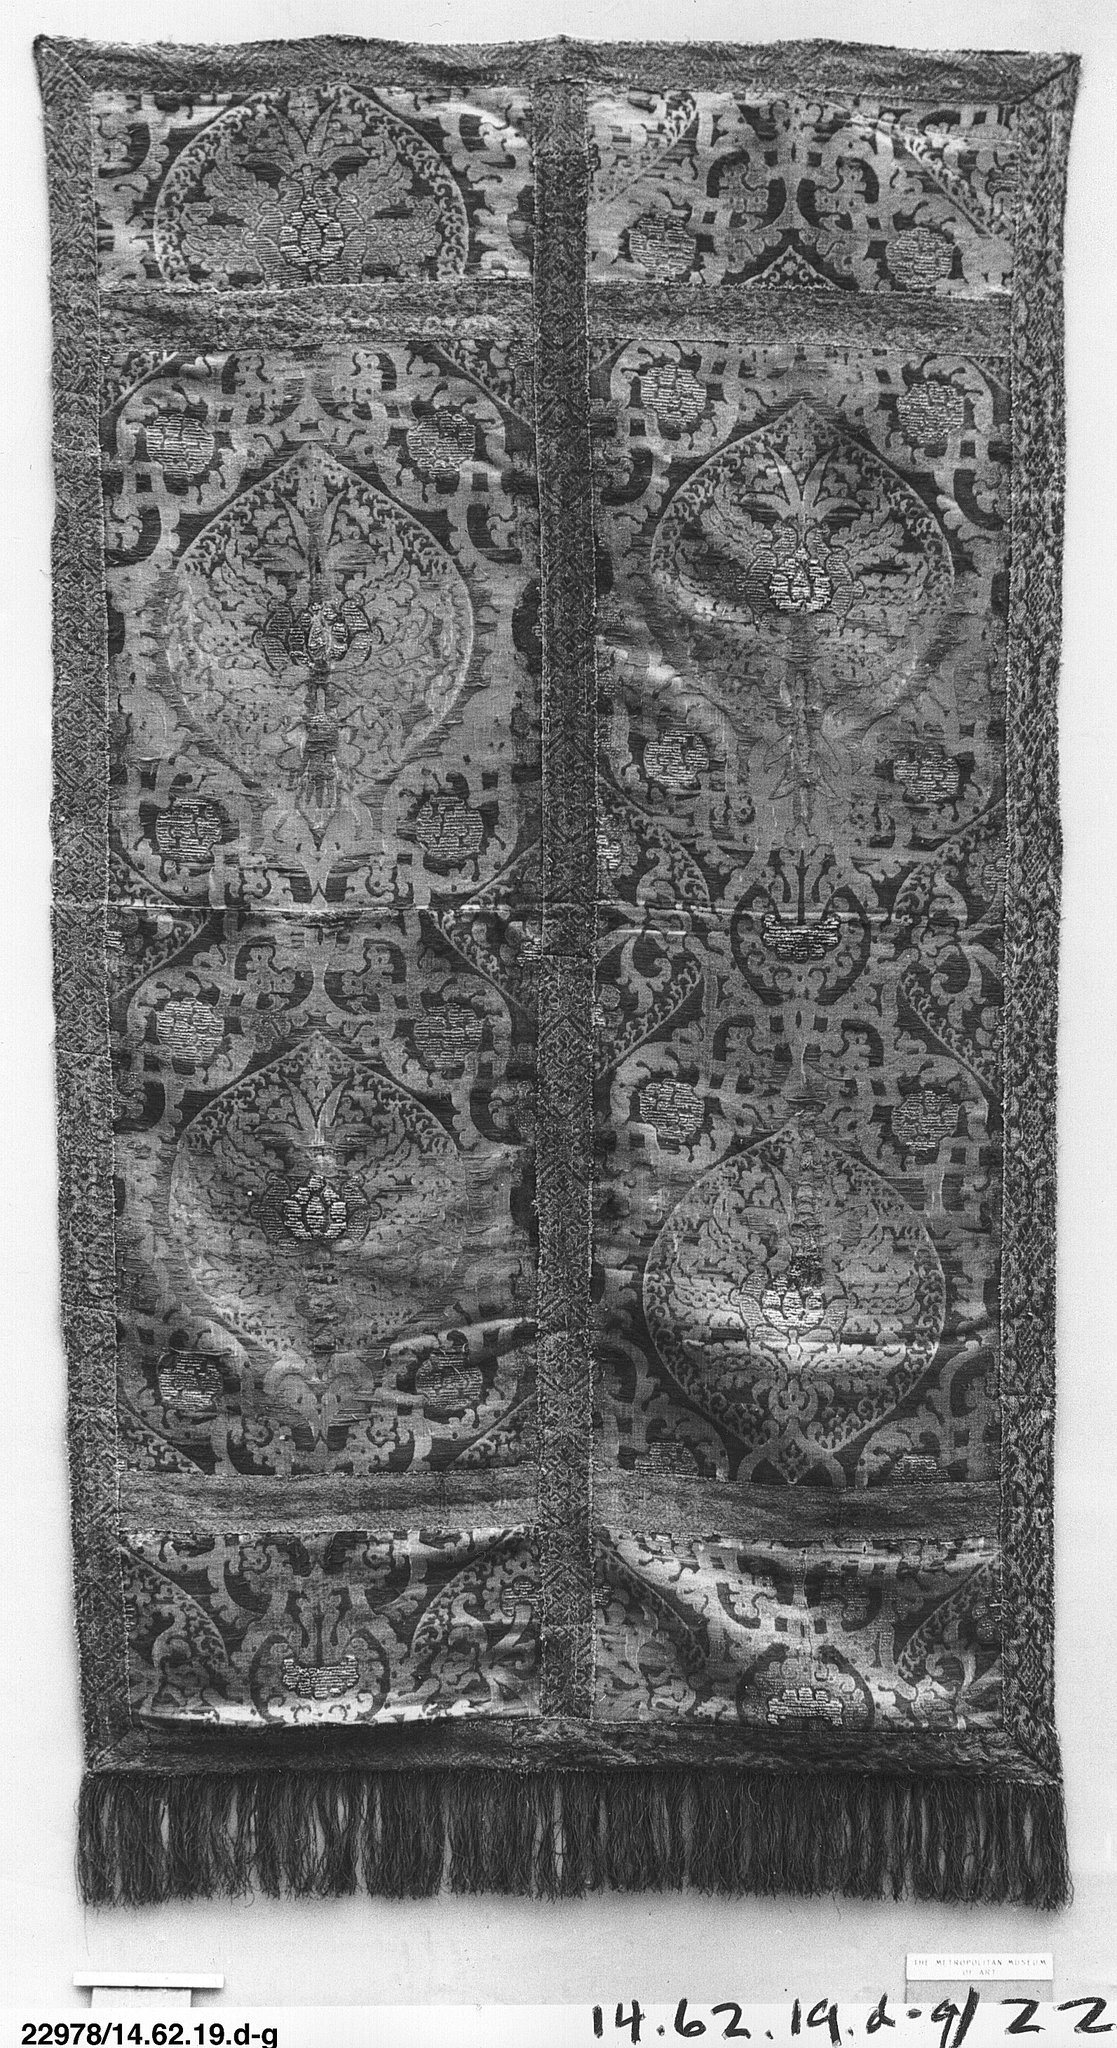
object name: piece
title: Pieces (4)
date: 1501-1600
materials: metal thread, silk